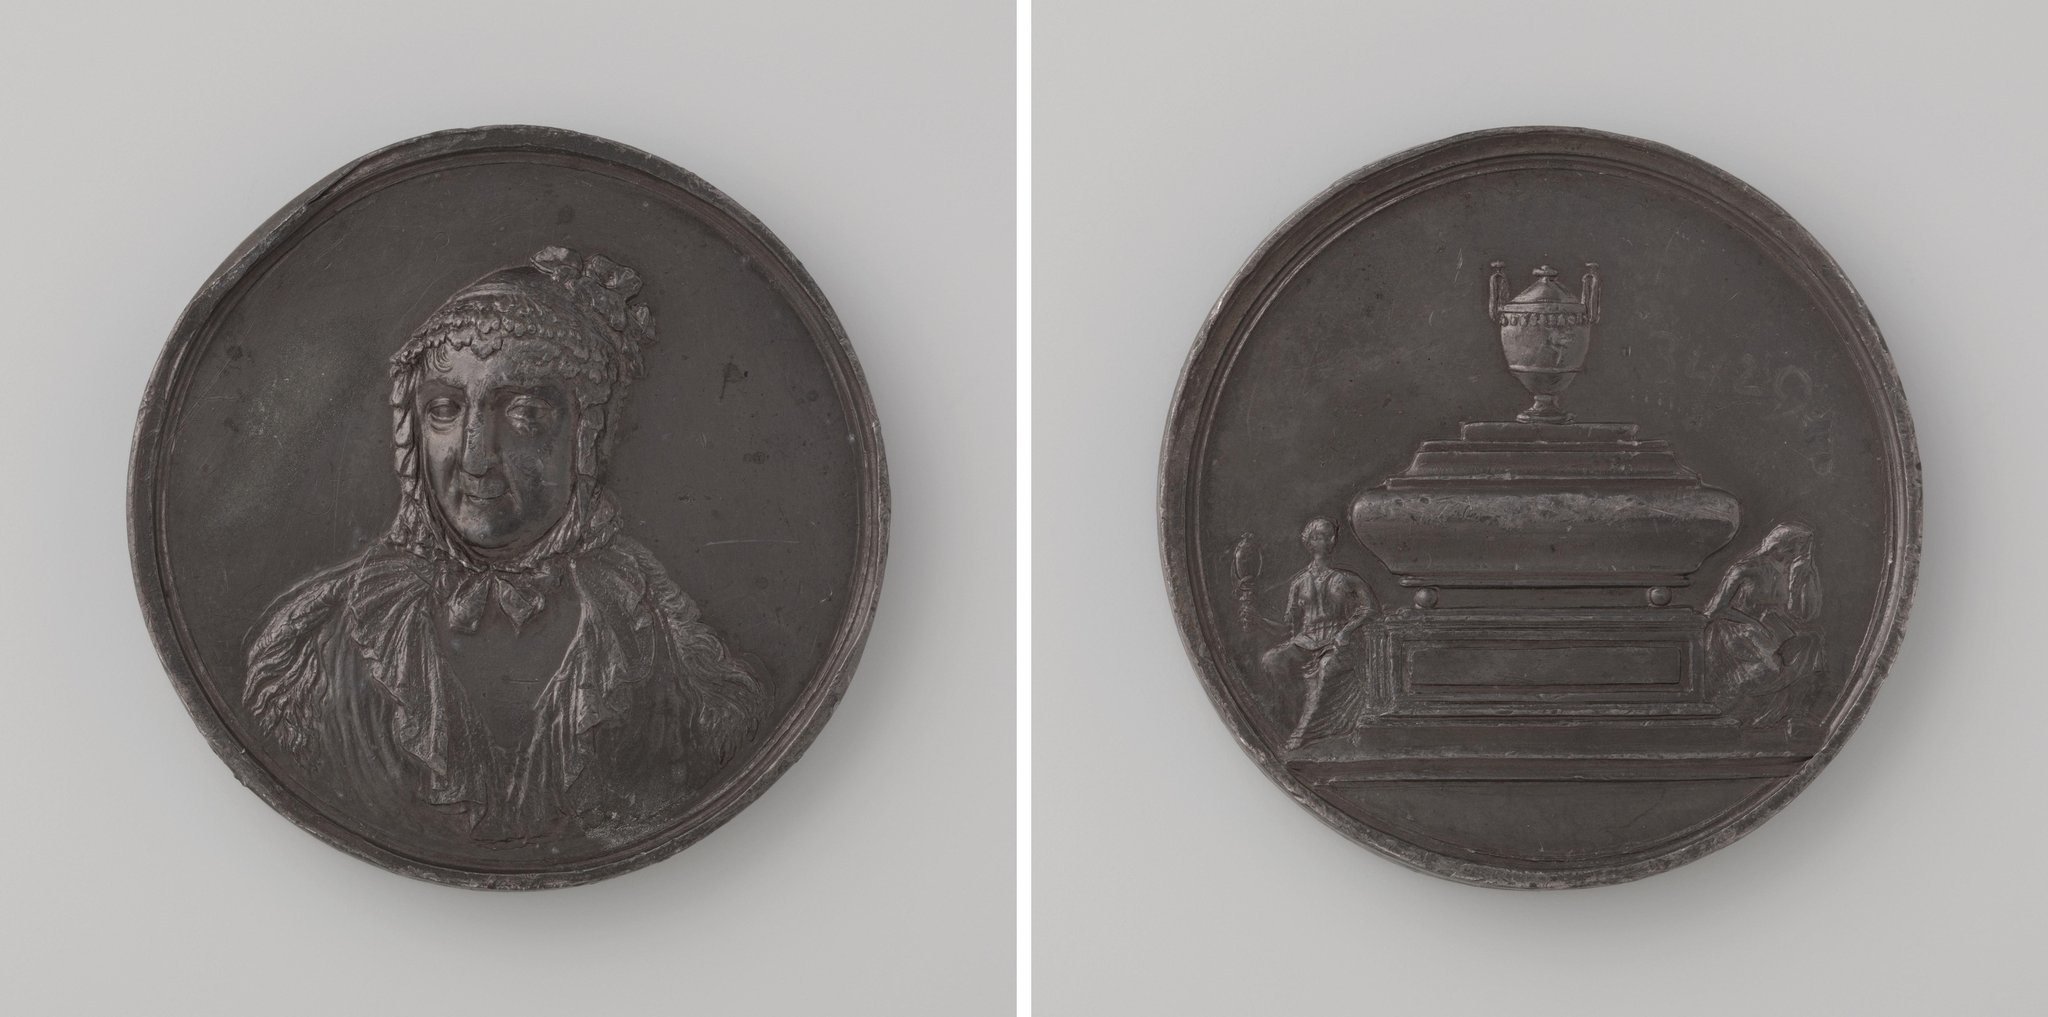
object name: history medal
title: Overlijden van Wilhelmina van Pruisen, weduwe van Willem V, prins van Oranje-Nassau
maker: adriaan bemme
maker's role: draughtsman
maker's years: 1753-1831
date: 1820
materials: lead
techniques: striking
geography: rotterdam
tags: berlin, painter, wilhelmina of prussia (princess of orange)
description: Overlijden van Wilhelmina van Pruisen, weduwe van Willem V, prins van Oranje-Nassau, in 1820. Loden penning. Voorzijde: borststuk vrouw. Keerzijde: tombe, waarop lijkbus is geplaatst, op sokkel; links vrouw met spiegel, waaromheen slang kronkelt, rechts wenende gesluierde vrouw met geopend boek op haar schoot